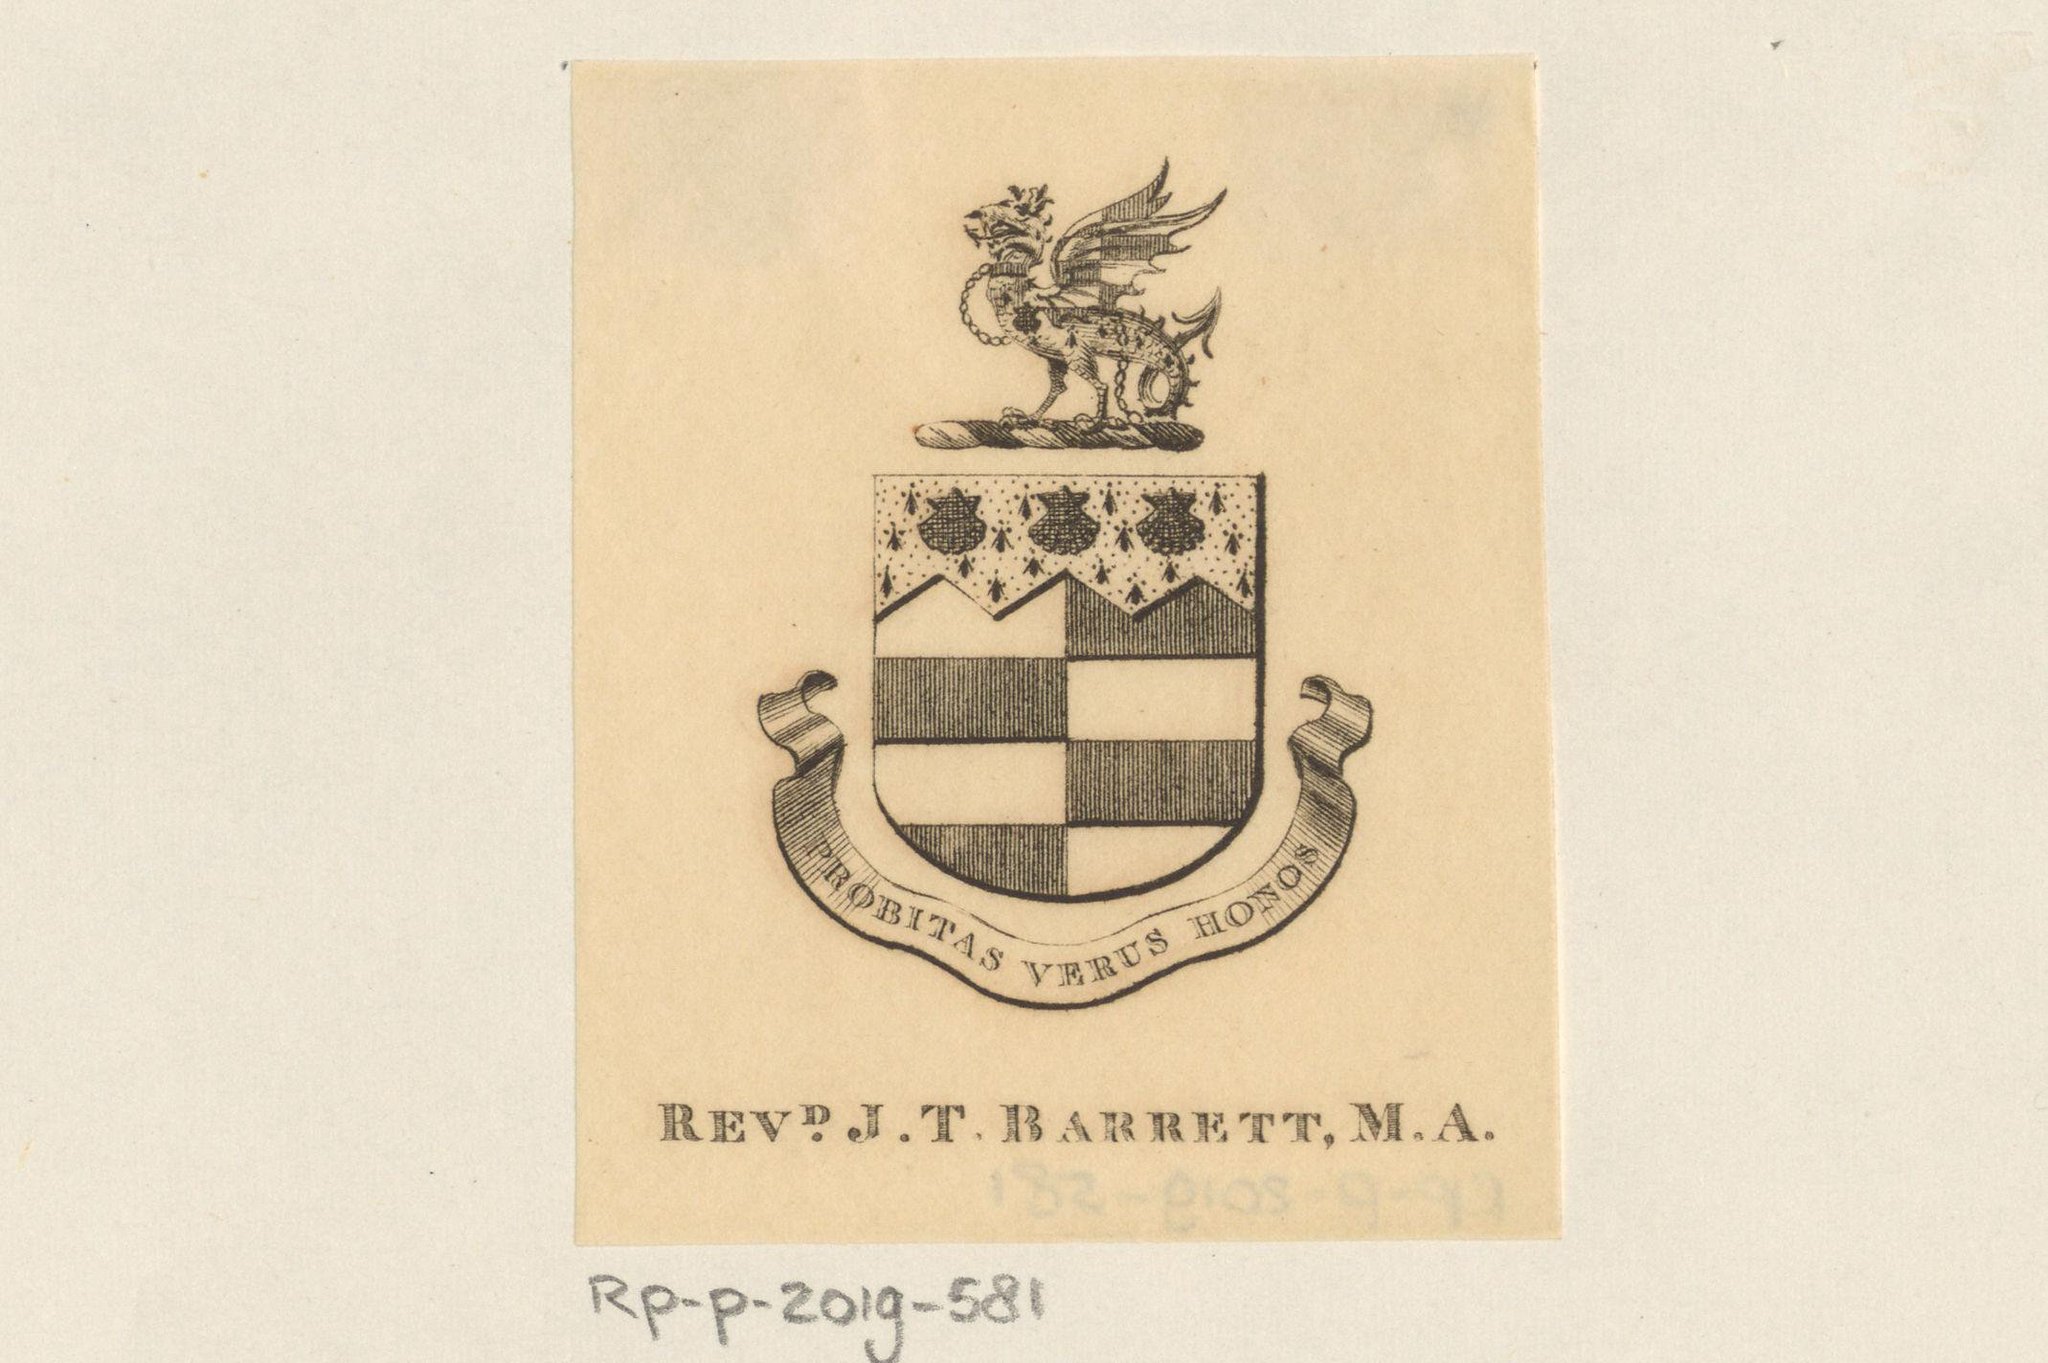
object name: bookplate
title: Ex libris van J.T. Barrett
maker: Anonymous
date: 1800-1899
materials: paper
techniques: etching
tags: armorial bearing, heraldry